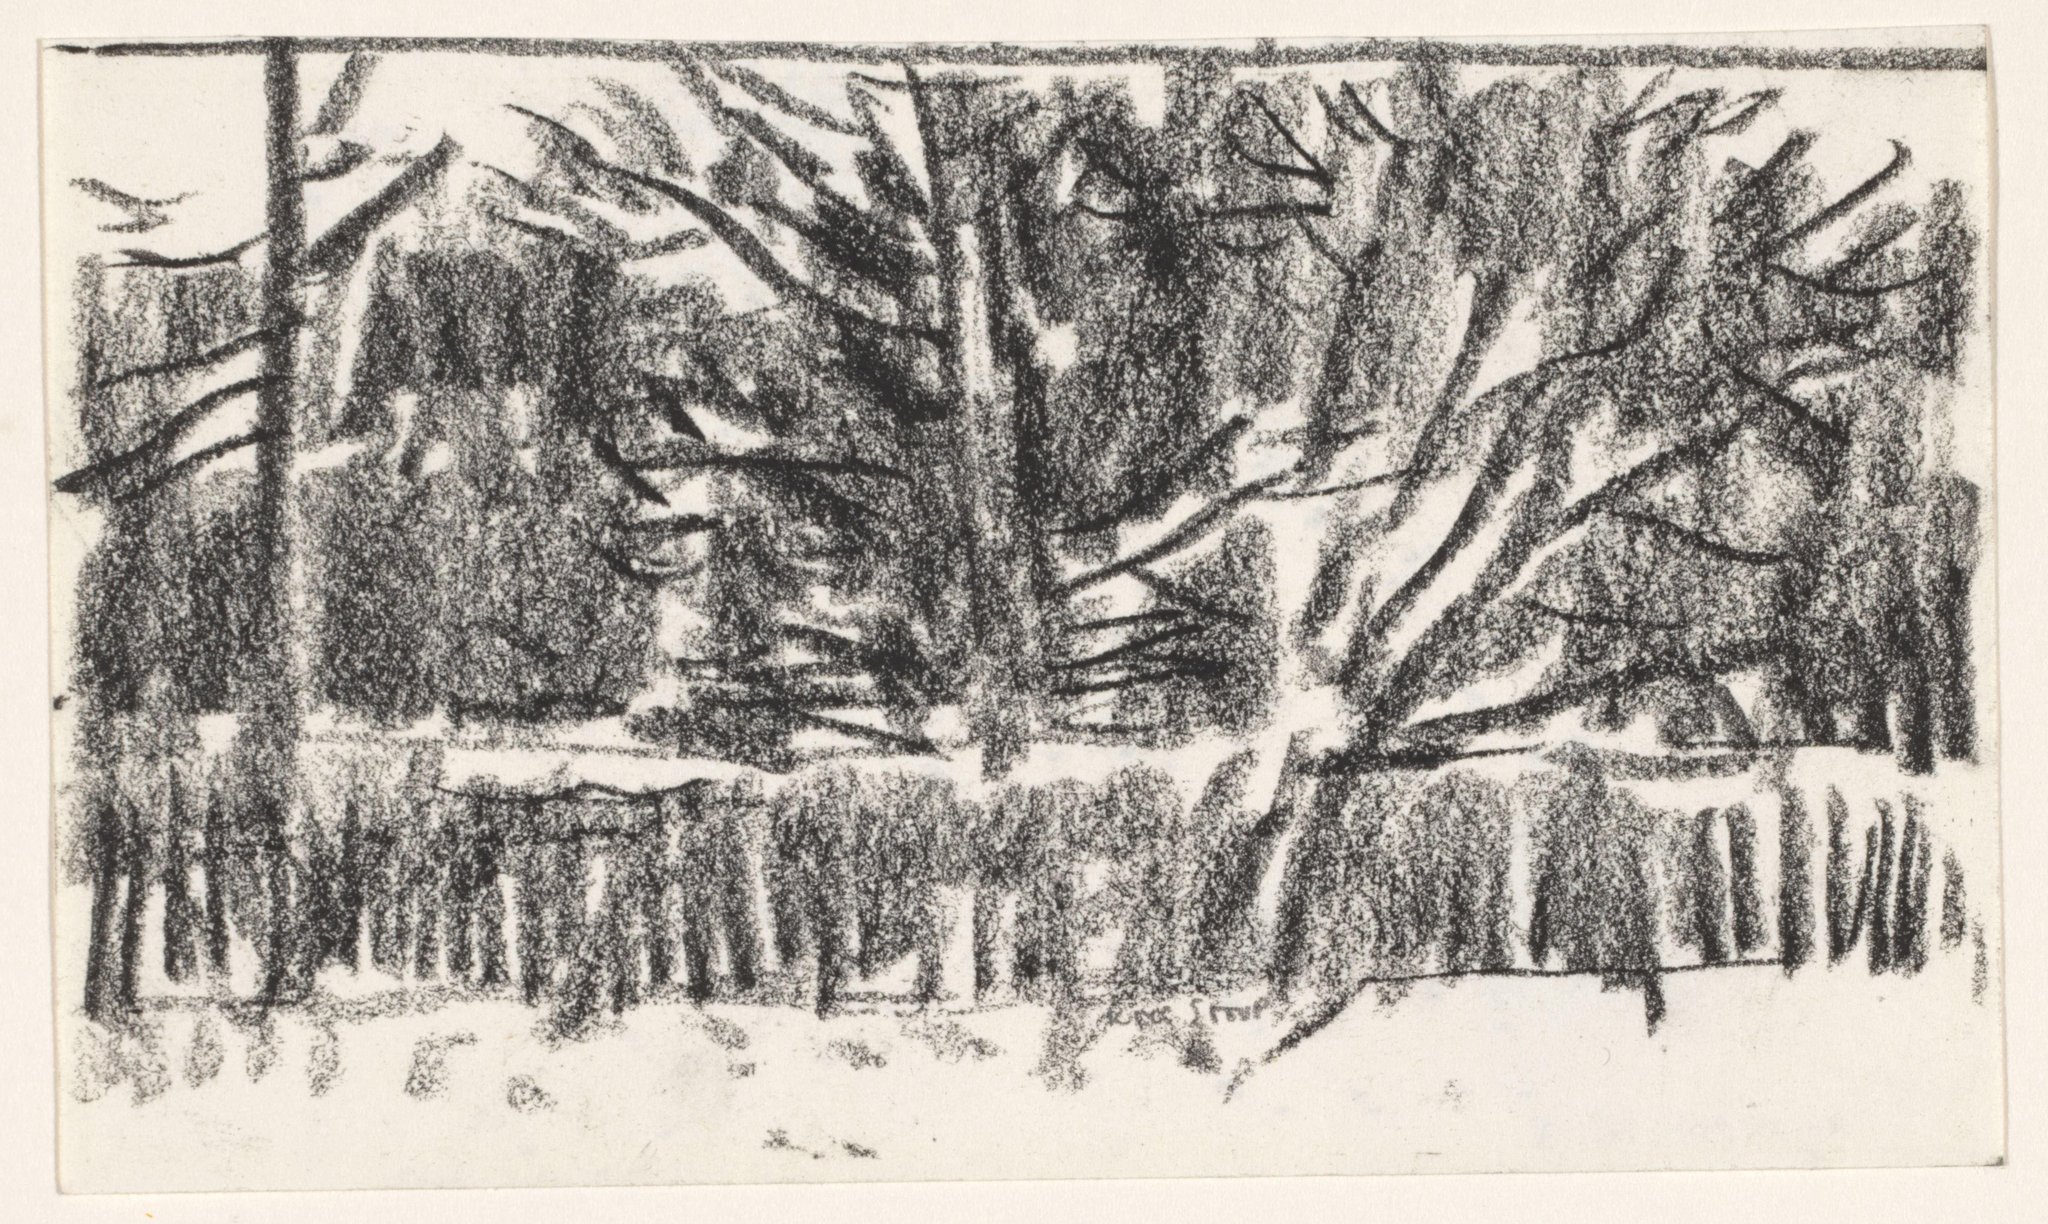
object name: drawing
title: Geboomte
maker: kees stoop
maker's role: draughtsman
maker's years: 1929-2019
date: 1939-2009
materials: charcoal, paper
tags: trees